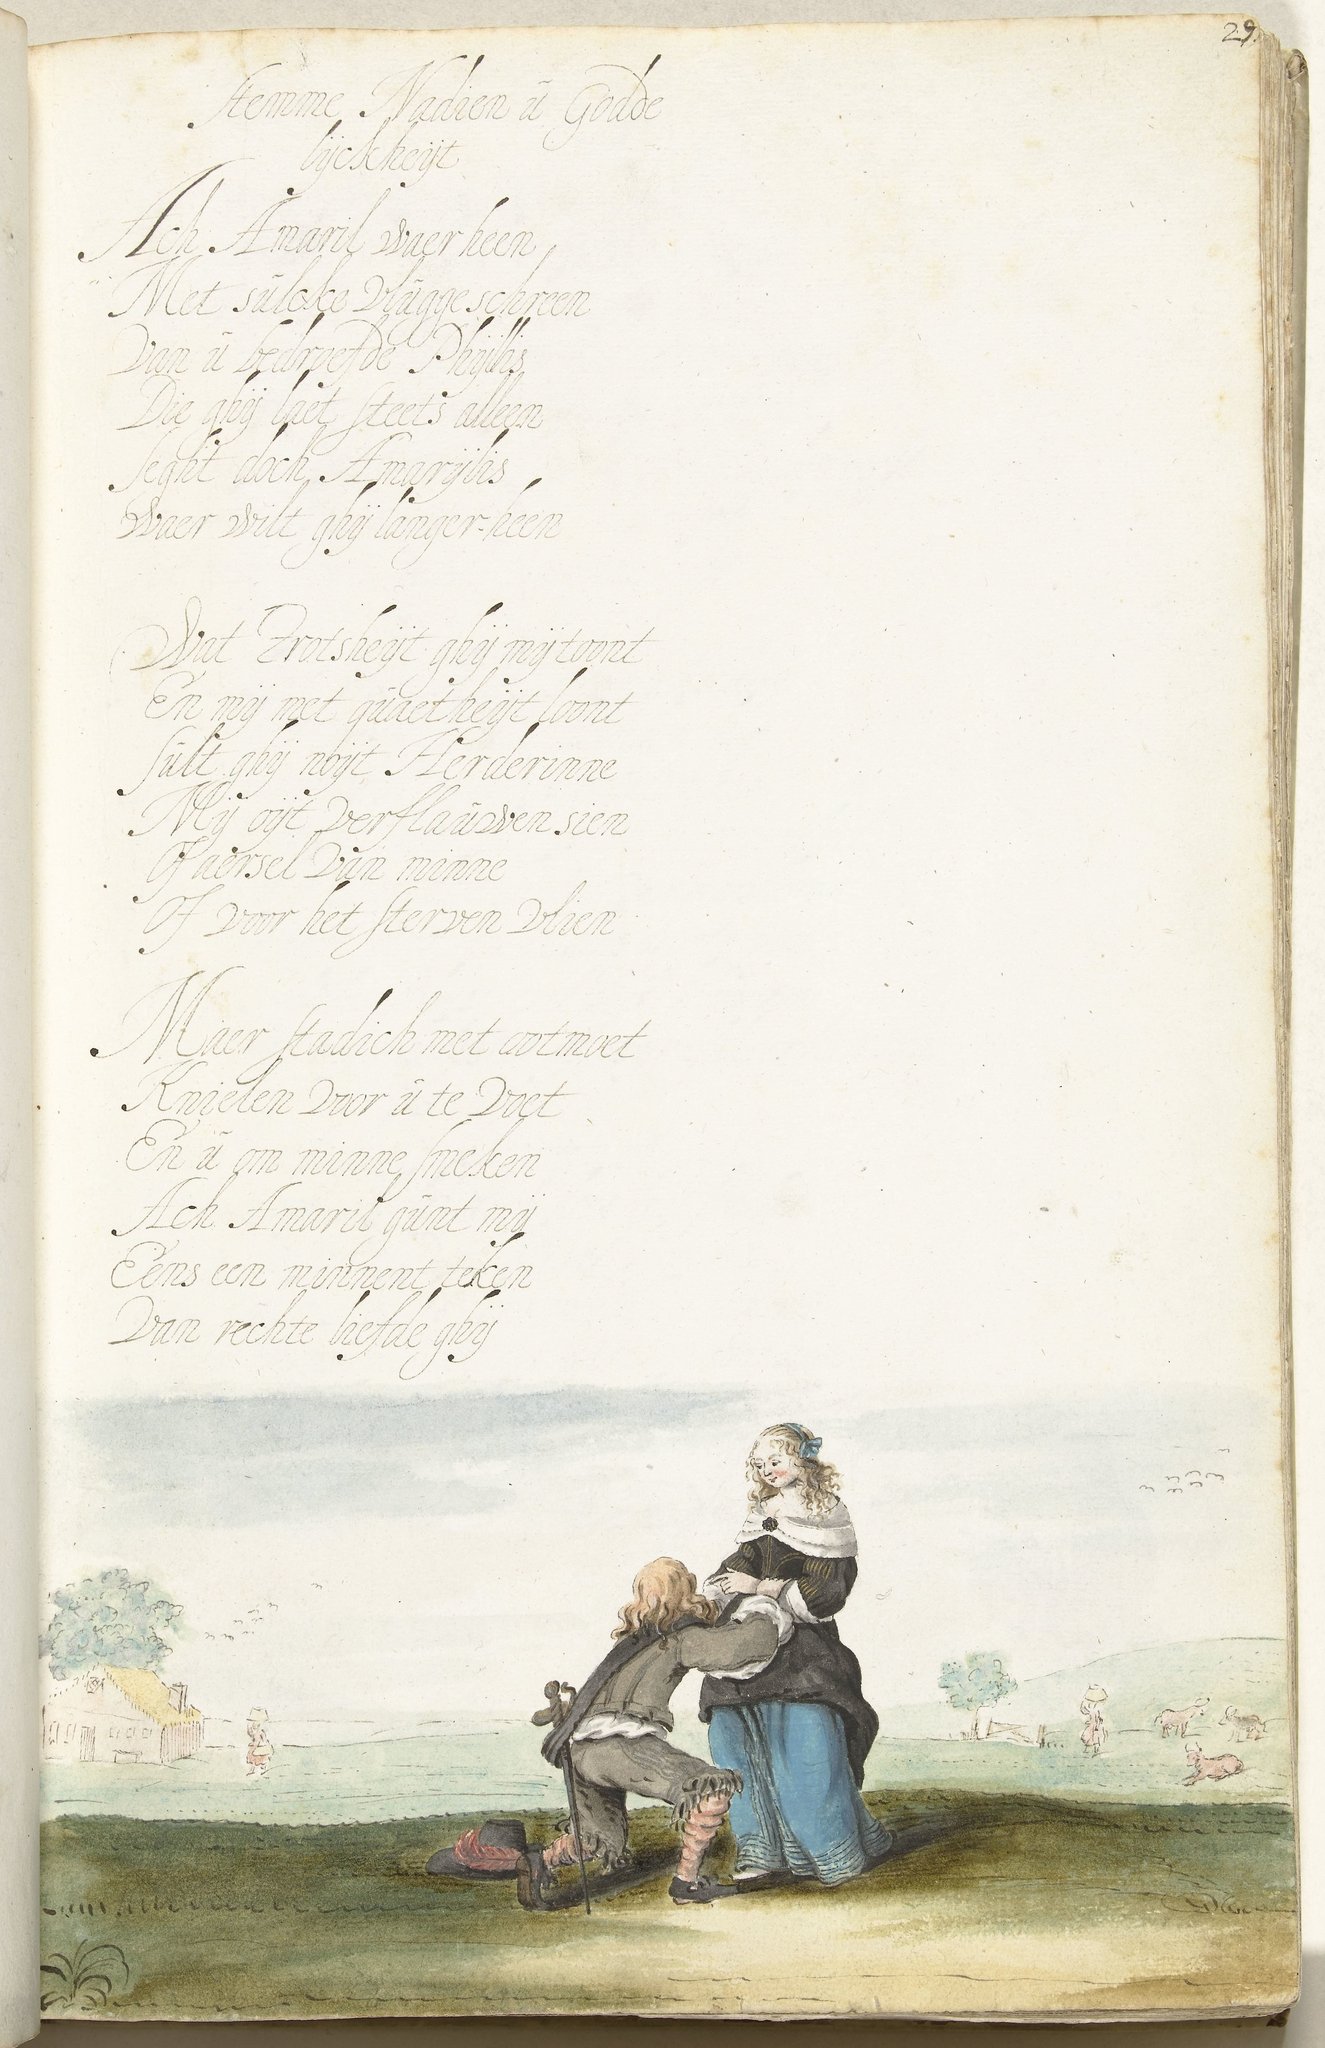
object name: watercolor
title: Heer knielend voor een jongedame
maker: gesina ter borch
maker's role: draughtsman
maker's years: 1633-1690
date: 1653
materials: ink, paper, watercolor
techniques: brush, calligraphy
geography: zwolle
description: Heer knielend voor een jongedame naast een liefdesklacht op de melodie van Nadien u goddelijckheijt.